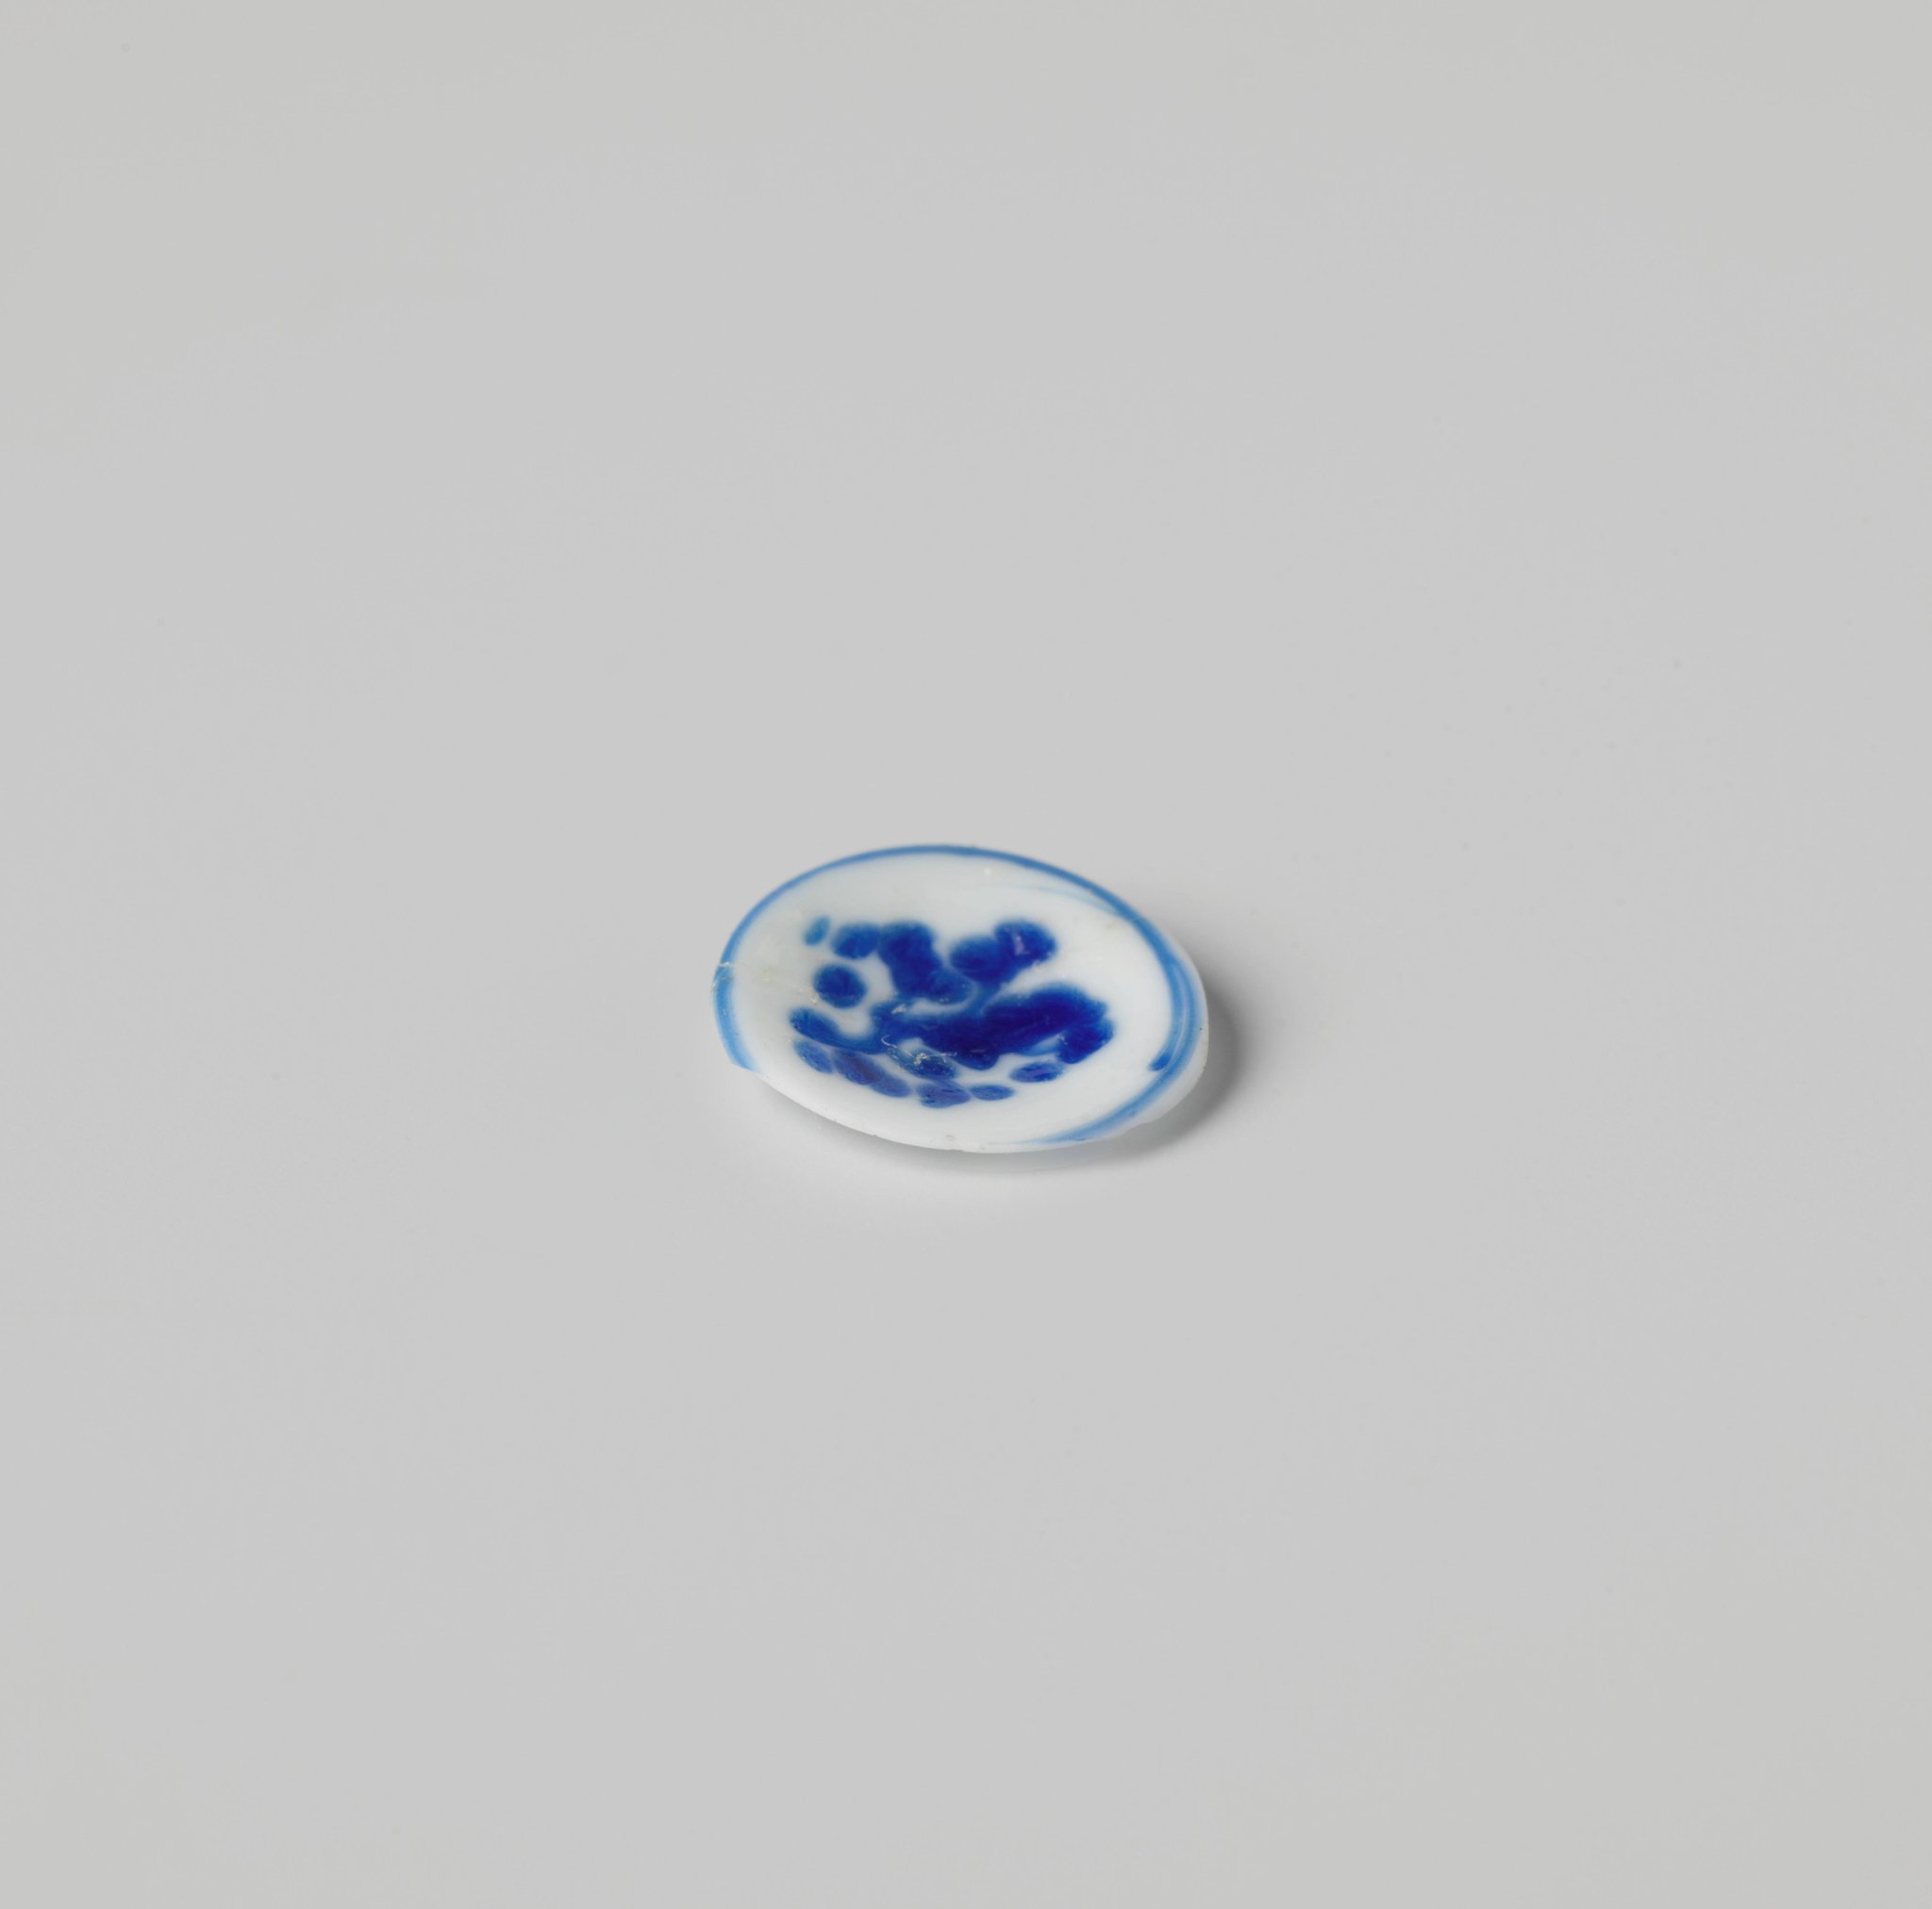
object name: miniature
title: Schotel, wit, beschilderd in blauw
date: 1675-1699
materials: glass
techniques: enamel painting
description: Schotel van melkglas met blauwe emailverf beschildering; dubbele laag en hol van binnen.